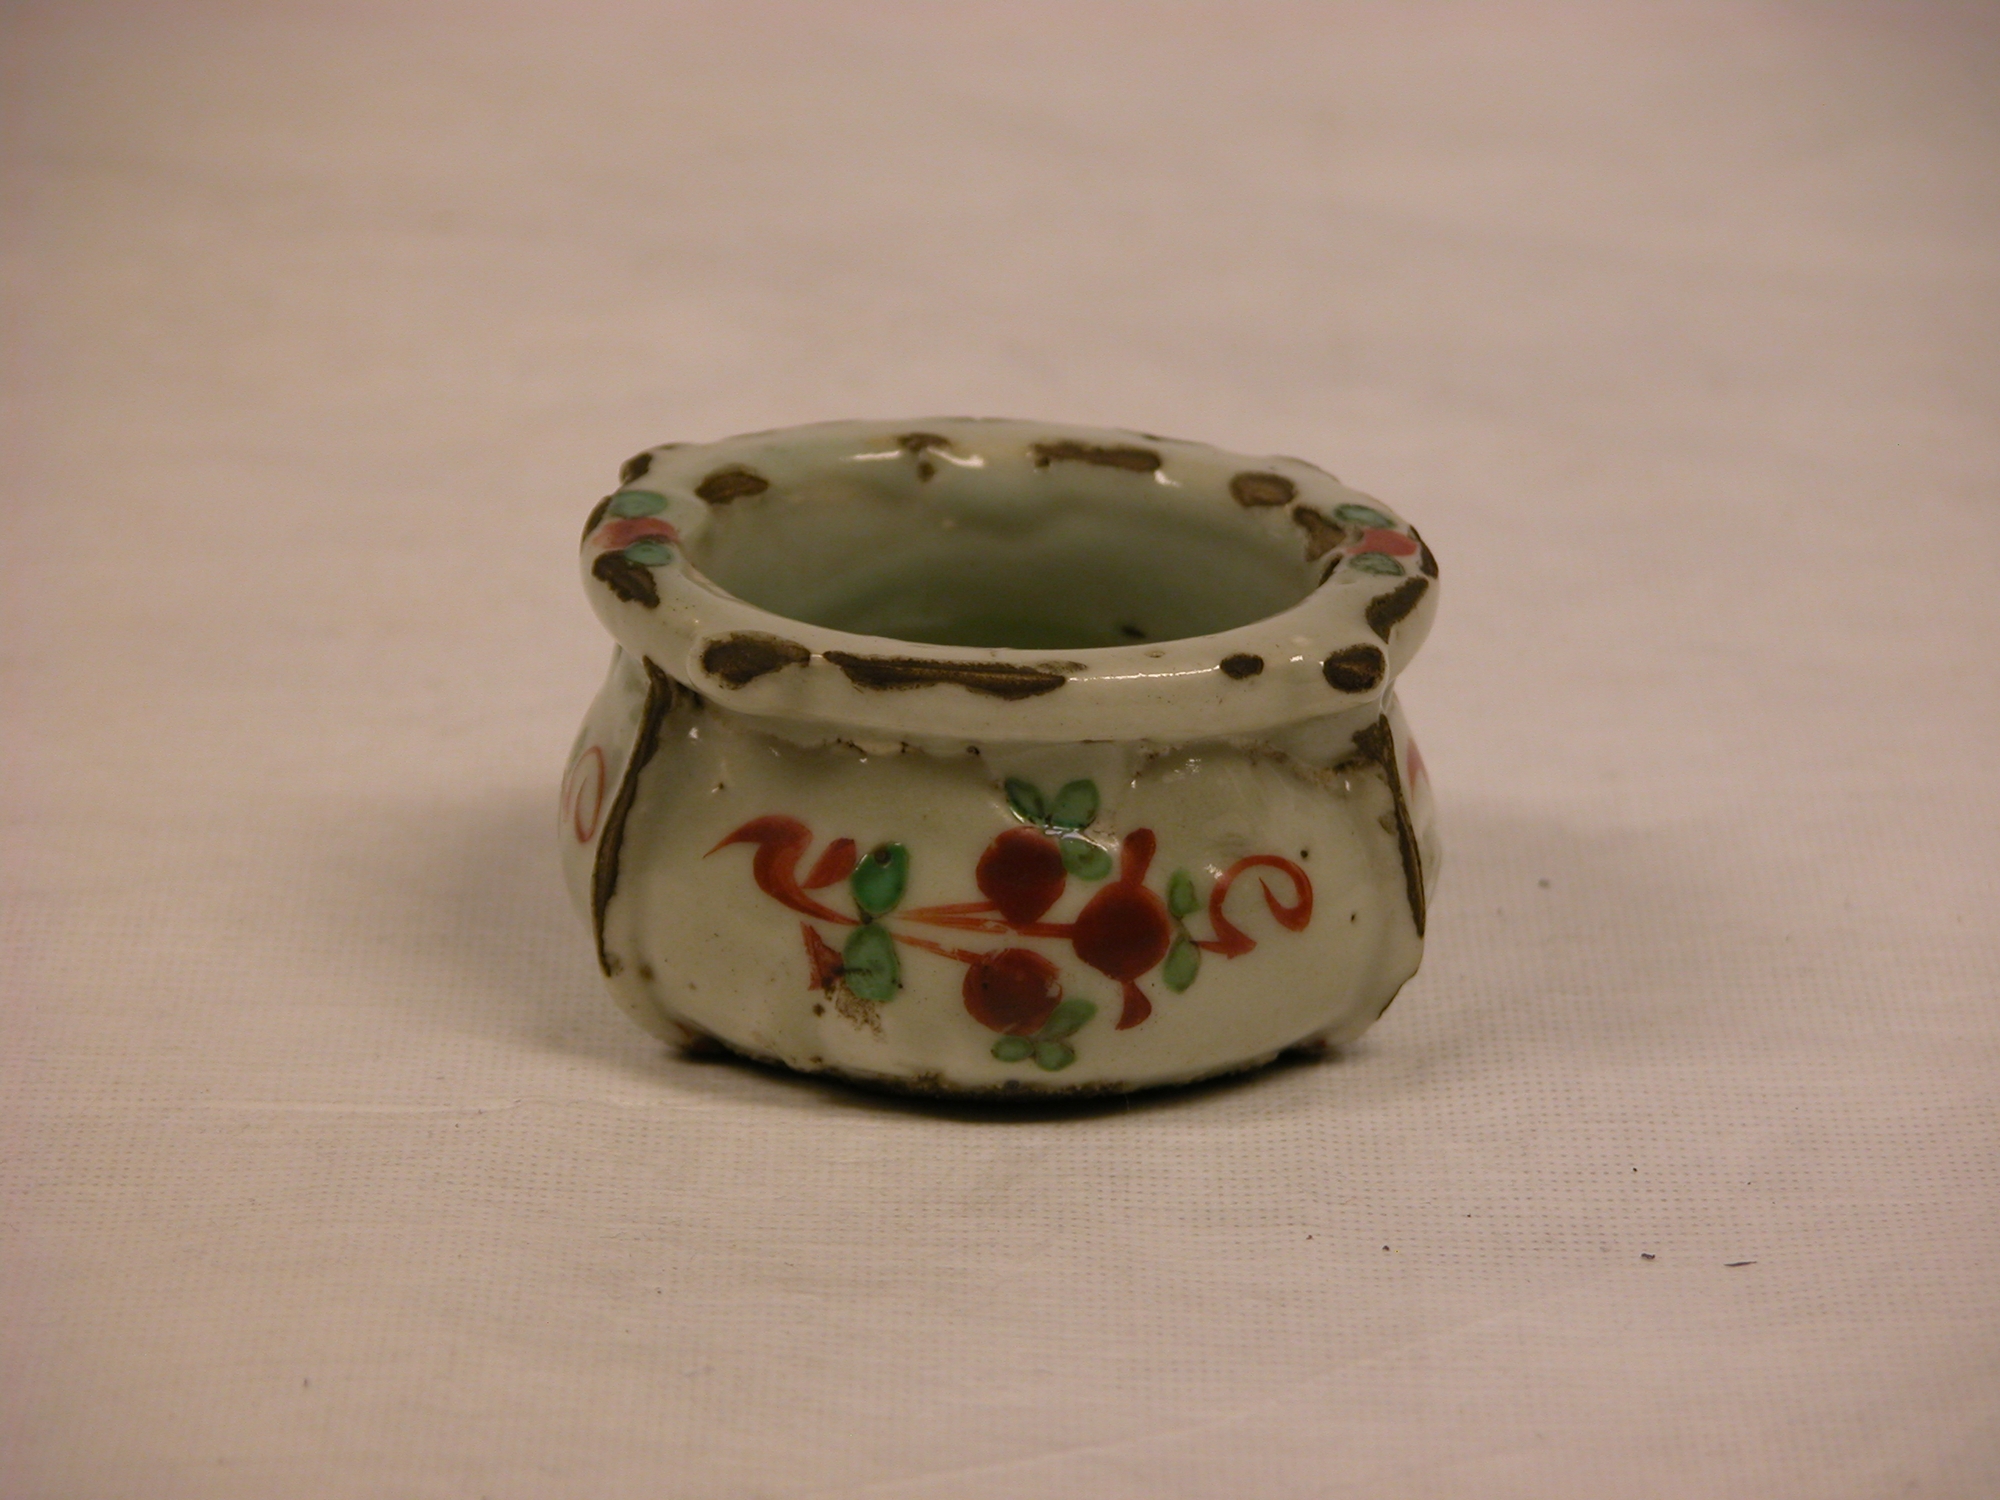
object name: pot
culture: chinese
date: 1650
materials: pottery